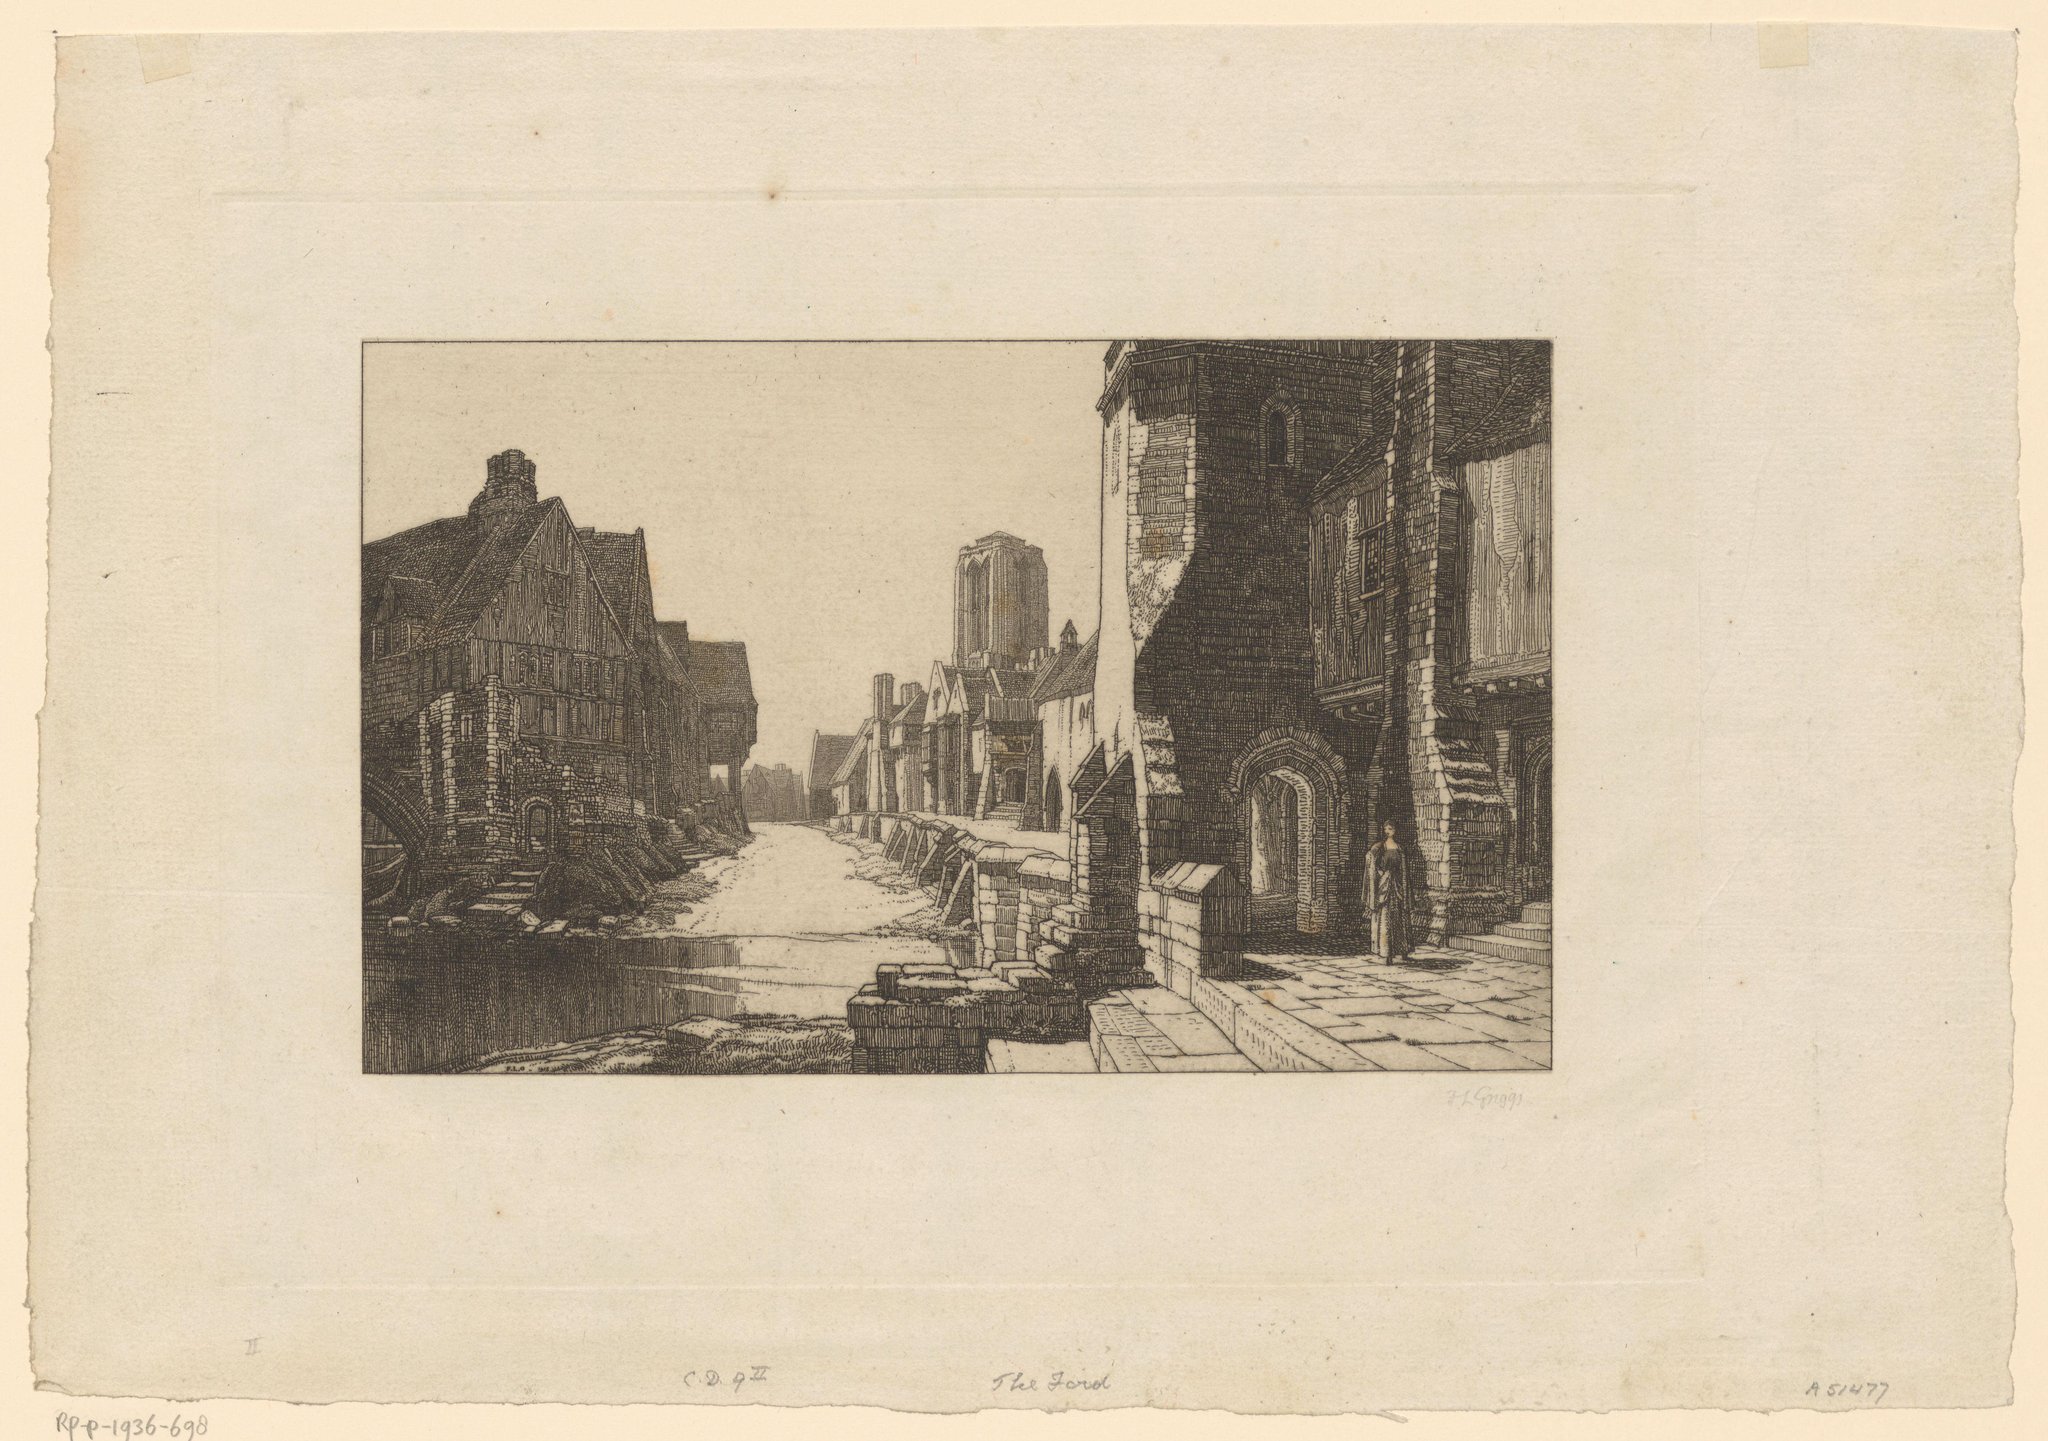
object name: print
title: The Ford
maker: frederick landseer maur griggs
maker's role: print maker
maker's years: 1876-1938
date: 1915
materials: paper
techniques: etching, intaglio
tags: urban housing, canals, waters (in city), parts of church exterior and annexes: tower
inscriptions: signature: ‘F.L. Griggs’, collector's mark: Lugt 2228